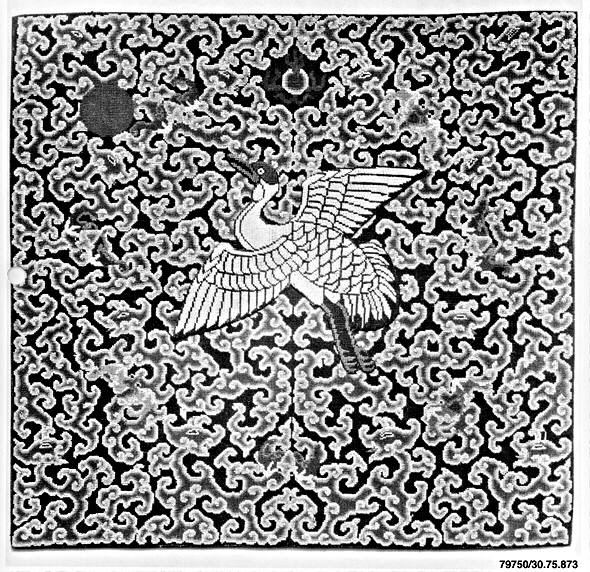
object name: rank badge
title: Rank Badge with Crane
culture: chinese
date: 1801-1900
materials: silk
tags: cranes